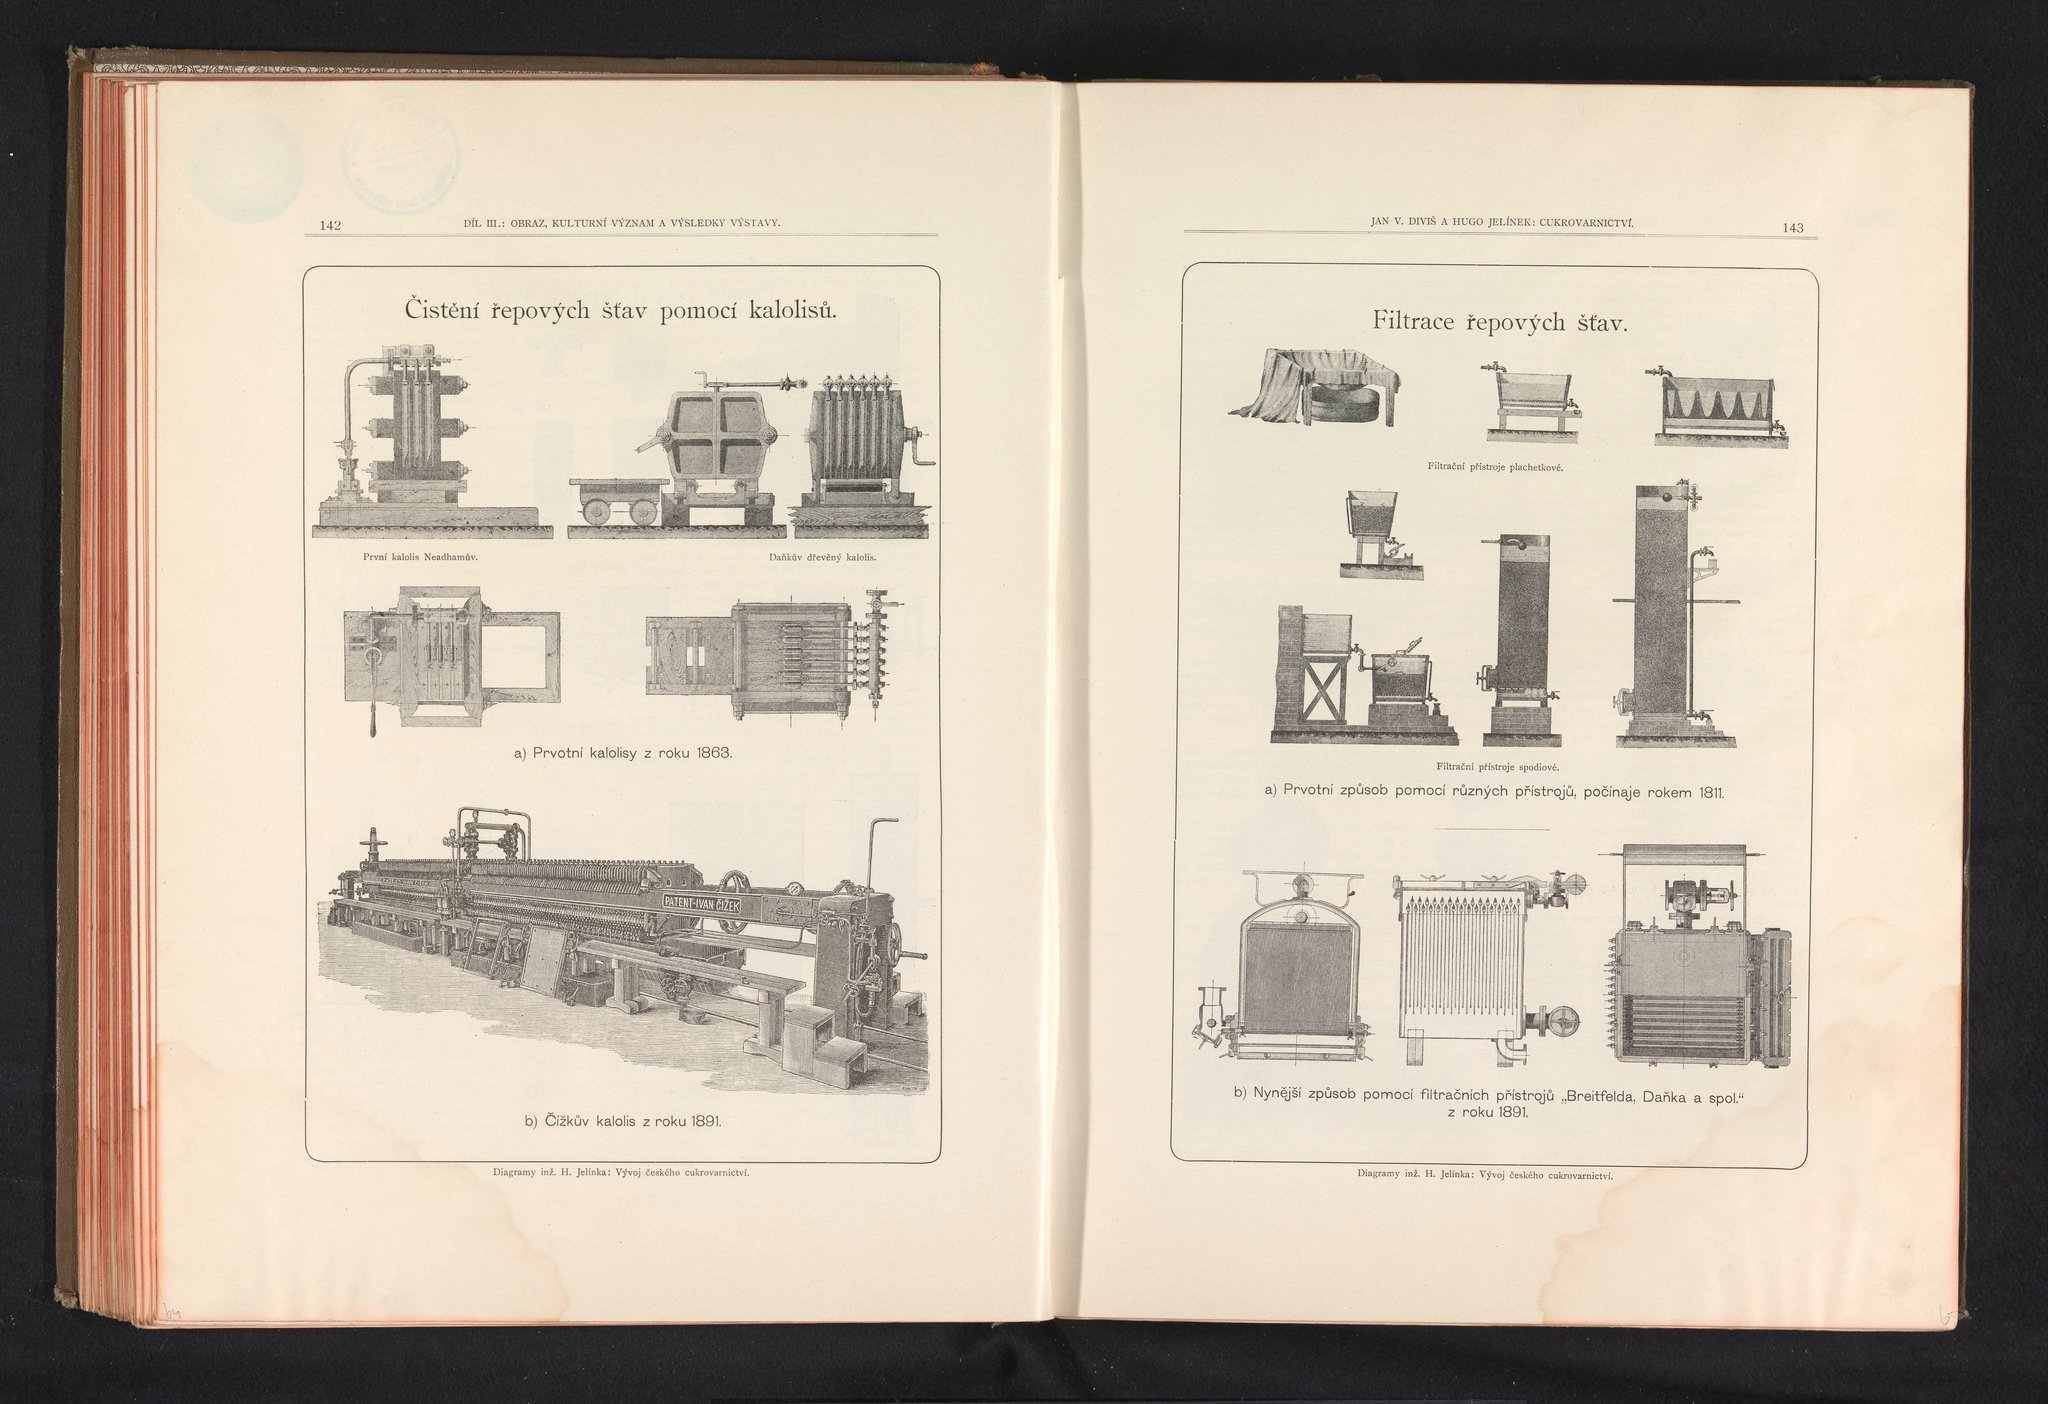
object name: photomechanical print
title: Fotoreproductie van een tekening, voorstellende filtreermachines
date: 1891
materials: paper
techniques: autotype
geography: prague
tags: machines; parts of machines; tools and appliances